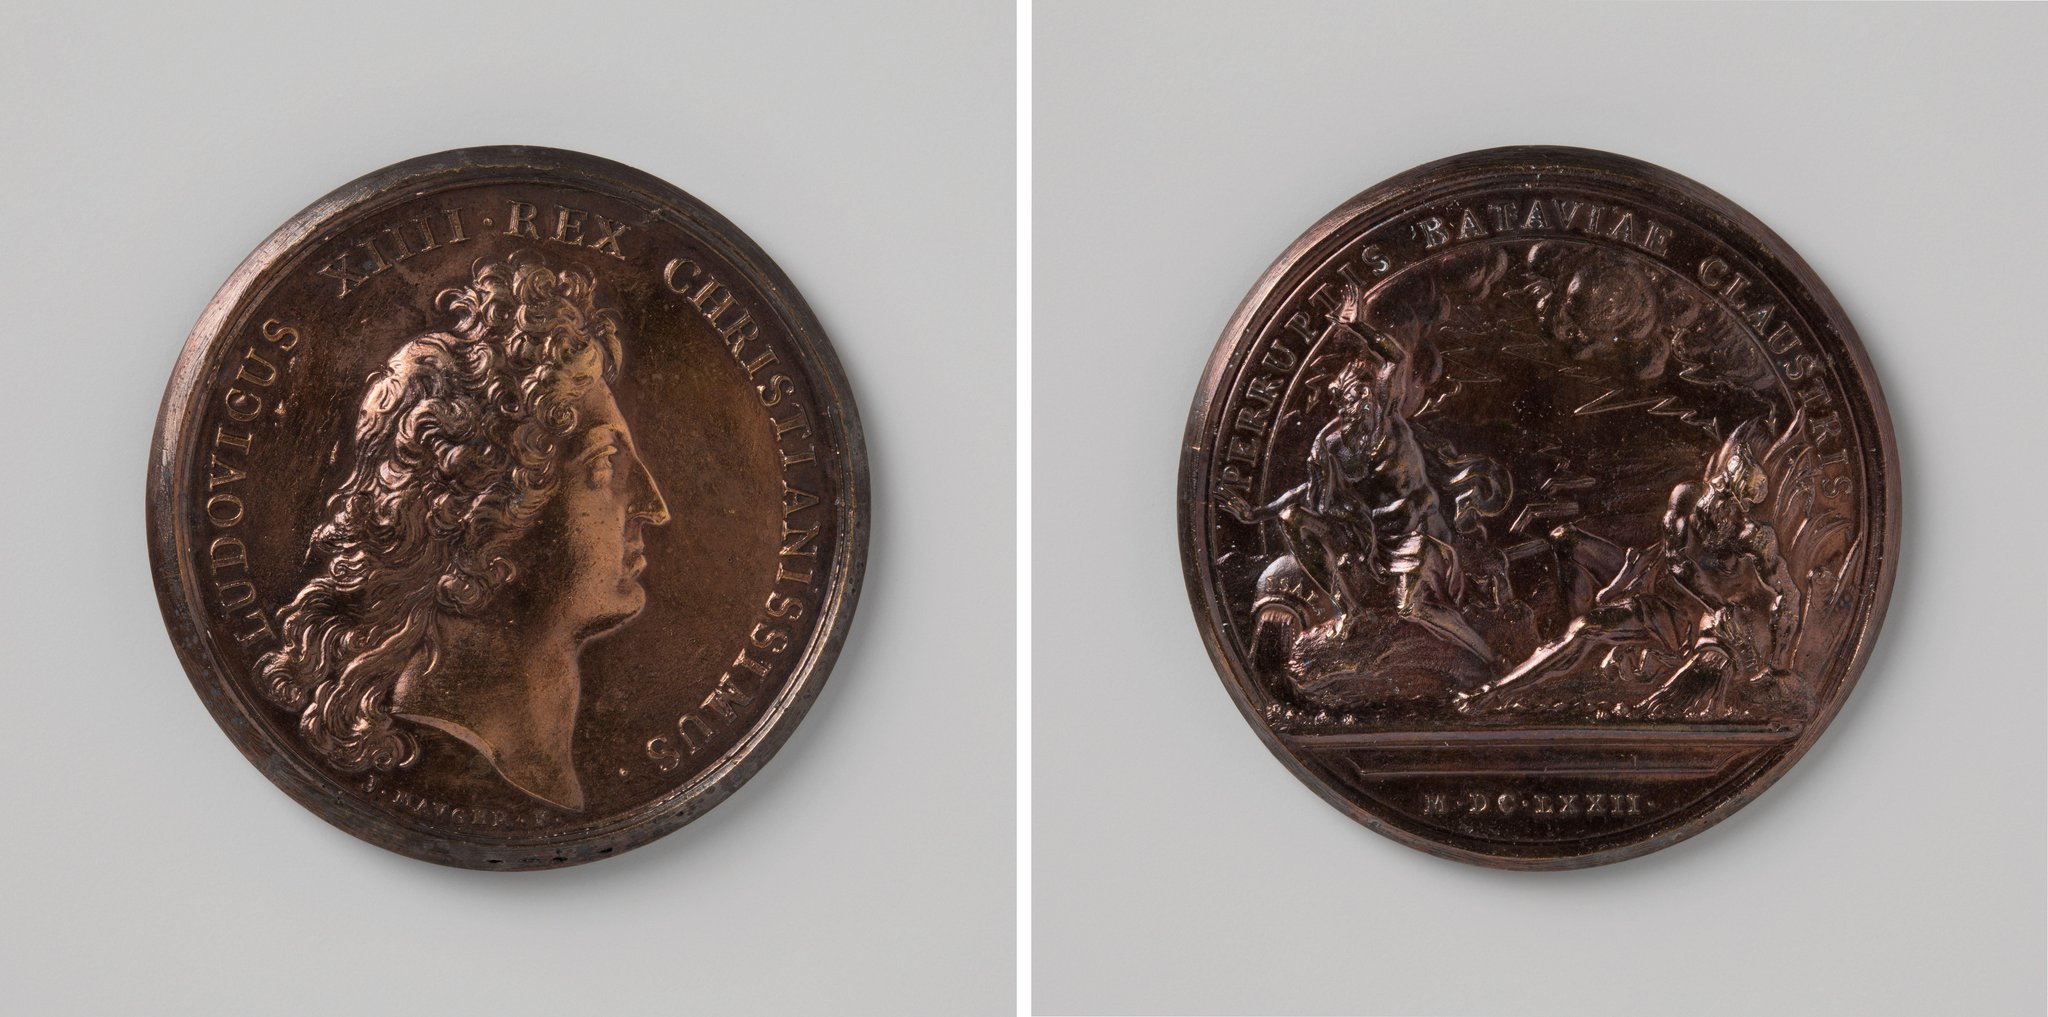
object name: history medal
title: Inval van Lodewijk XIV in Gelderland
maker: jean mauger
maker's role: medailleur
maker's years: 1648-1722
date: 1699-1703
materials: bronze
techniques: striking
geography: paris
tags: lodewijk xiv (koning van frankrijk), gelderland, rampjaar (disaster year)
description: Bronzen penning. Voorzijde: borststuk man (Lodewijk XIV) binnen omschrift. Keerzijde: Rijn en IJssel verschrikt door plotseling uitbrekend noodweer binnen omschrift.